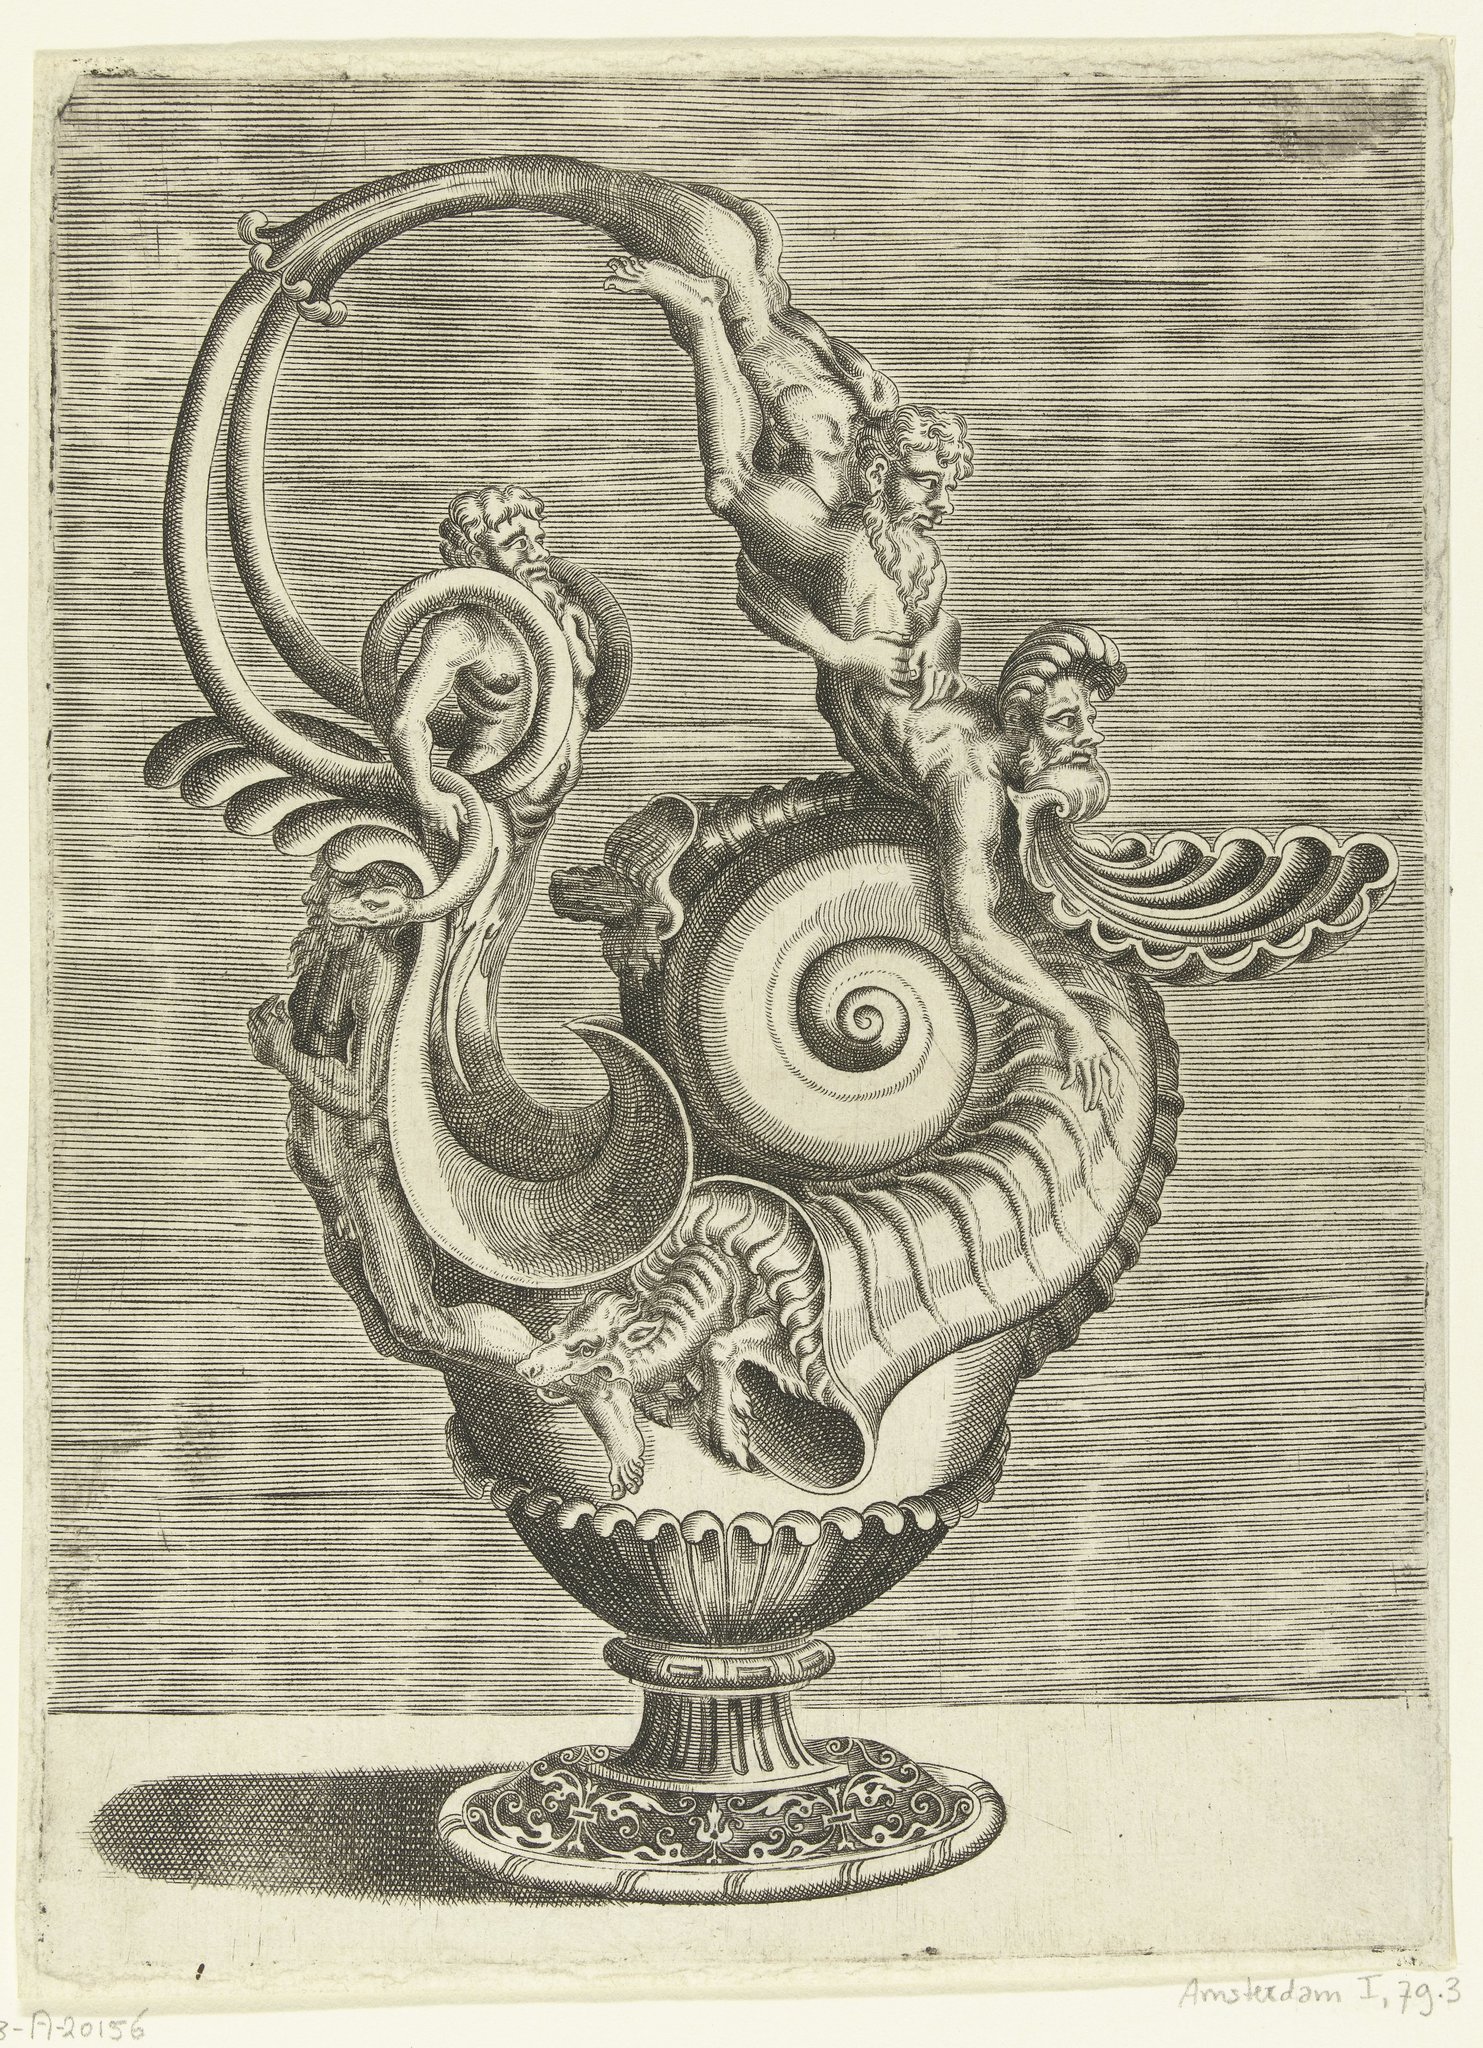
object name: print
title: Kan in de vorm van een slakkenhuis, met een oor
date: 1548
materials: paper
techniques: engraving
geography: netherlands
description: Het bovenste deel van het oor wordt gevormd door een man die een tweede man bij zijn middel vasthoudt. De tweede man heeft een onderkaak in de vorm van een schelp die de tuit van de kan vormt. Afkomstig uit een serie bestaande uit een titelblad en 20 bladen.